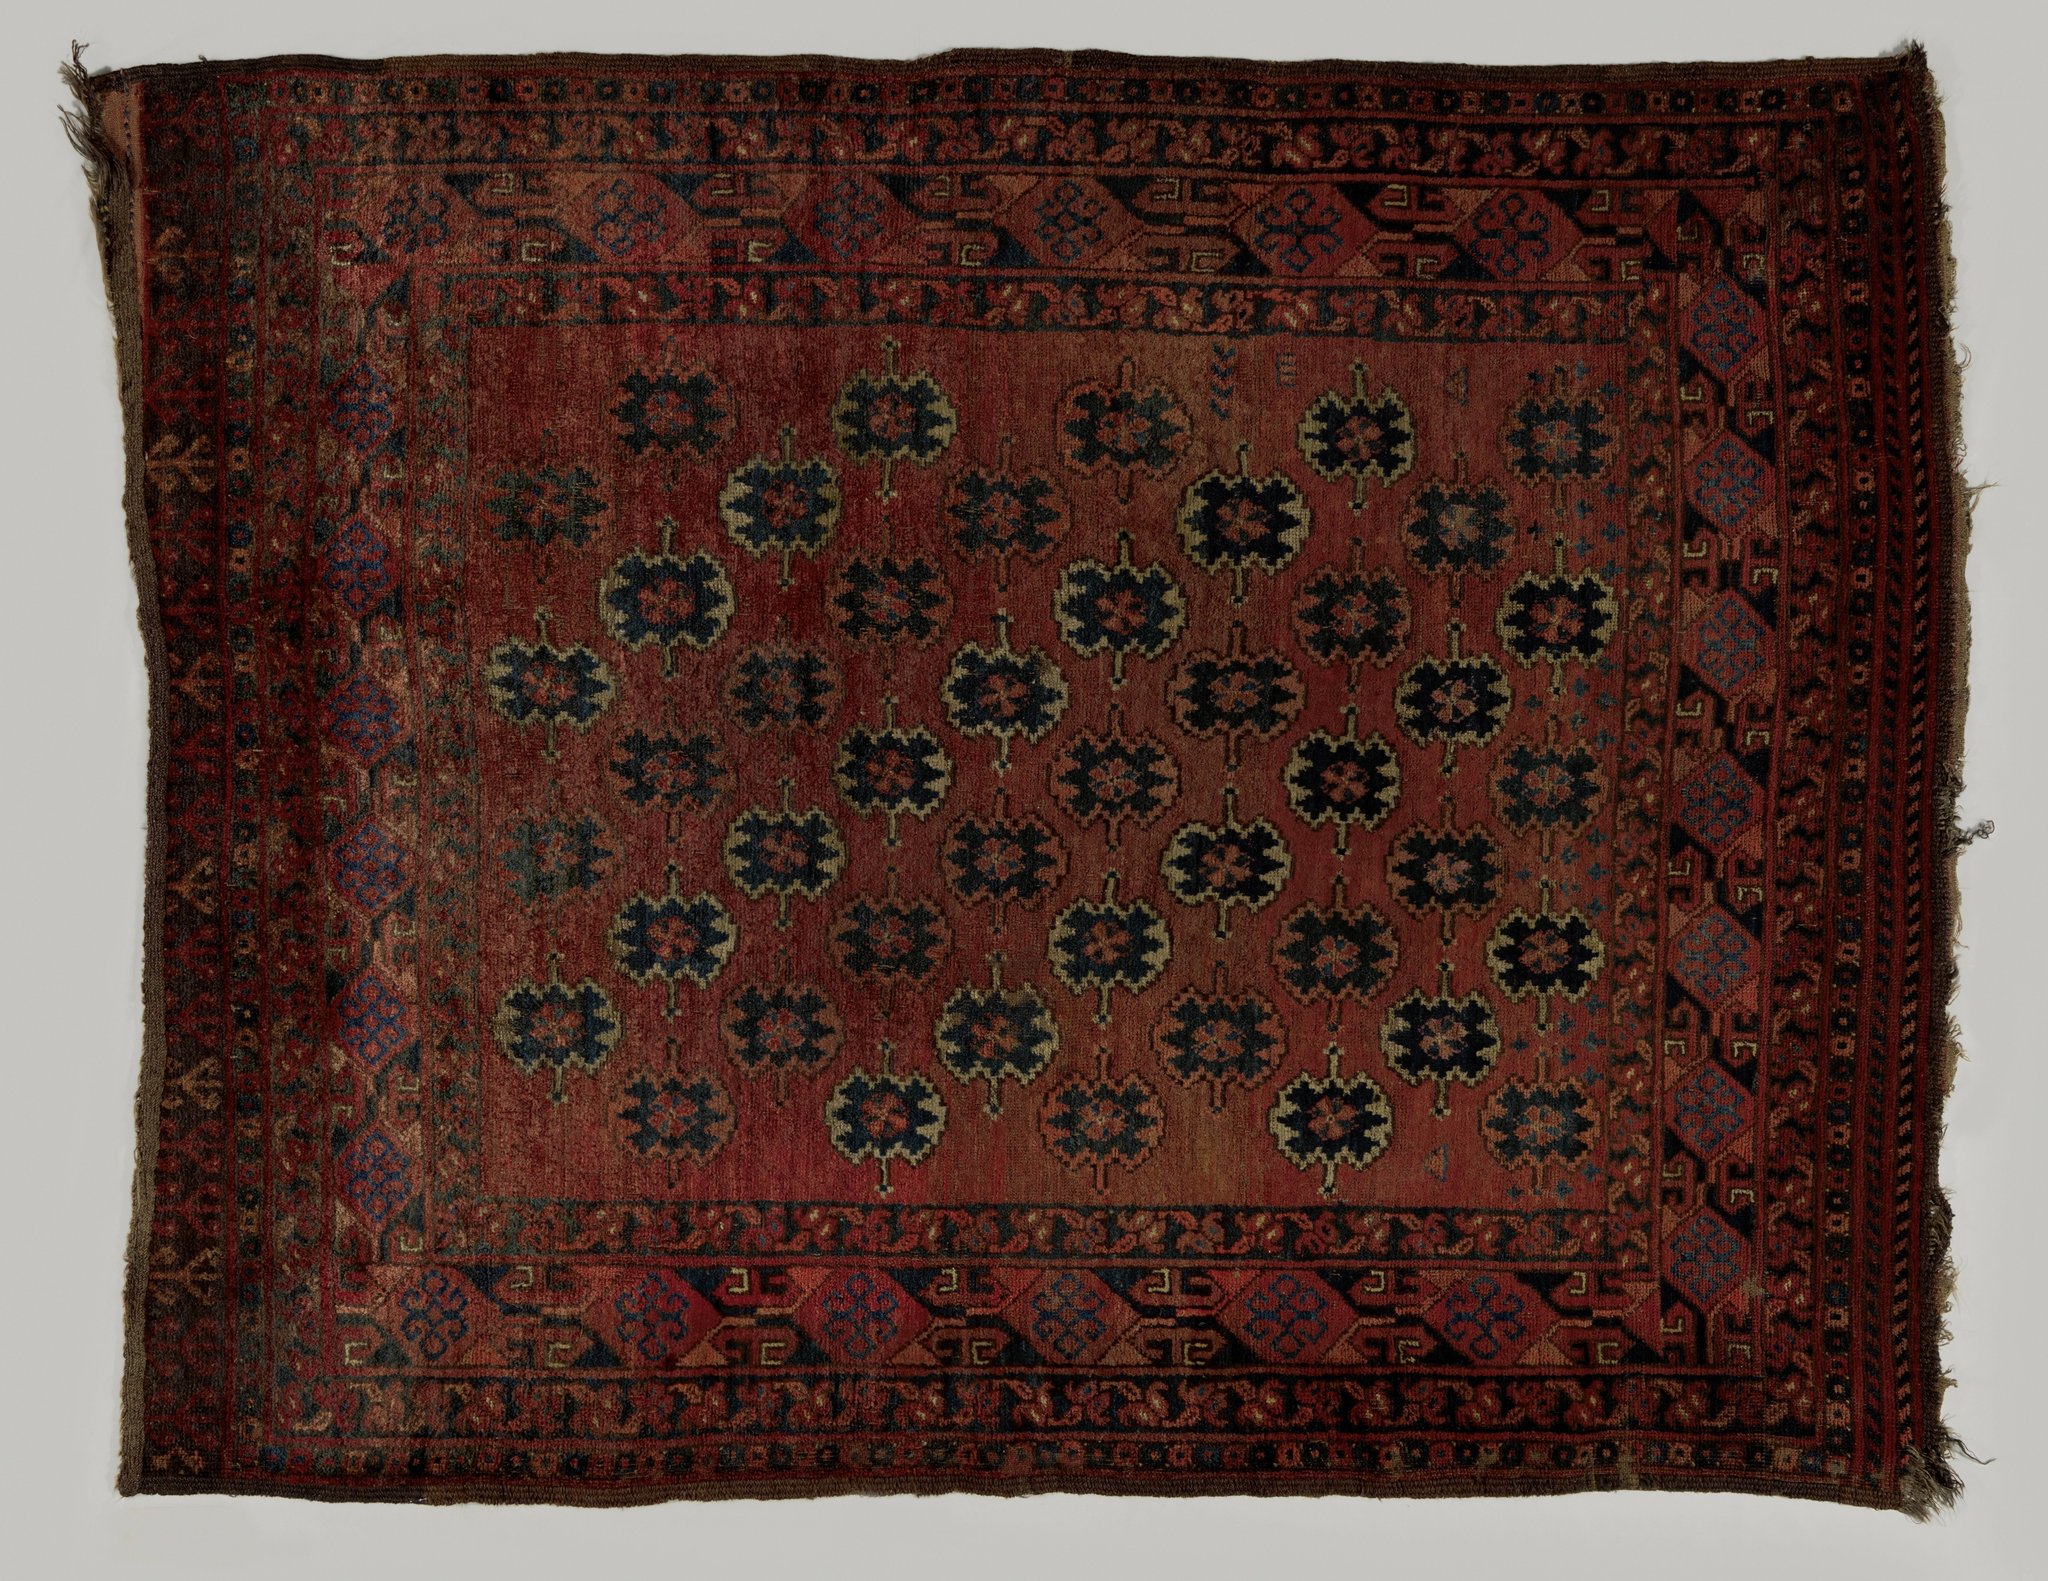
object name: oriental rug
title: Oosters tapijt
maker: Anonymous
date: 1875-1925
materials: animal fiber, wool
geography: central asia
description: Oosters tapijt, bloemenkleed. In het middenveld staan verspringende rijen bloemen. Viervoudige rand. Vierdubbele rank. Baard met borduursteken.